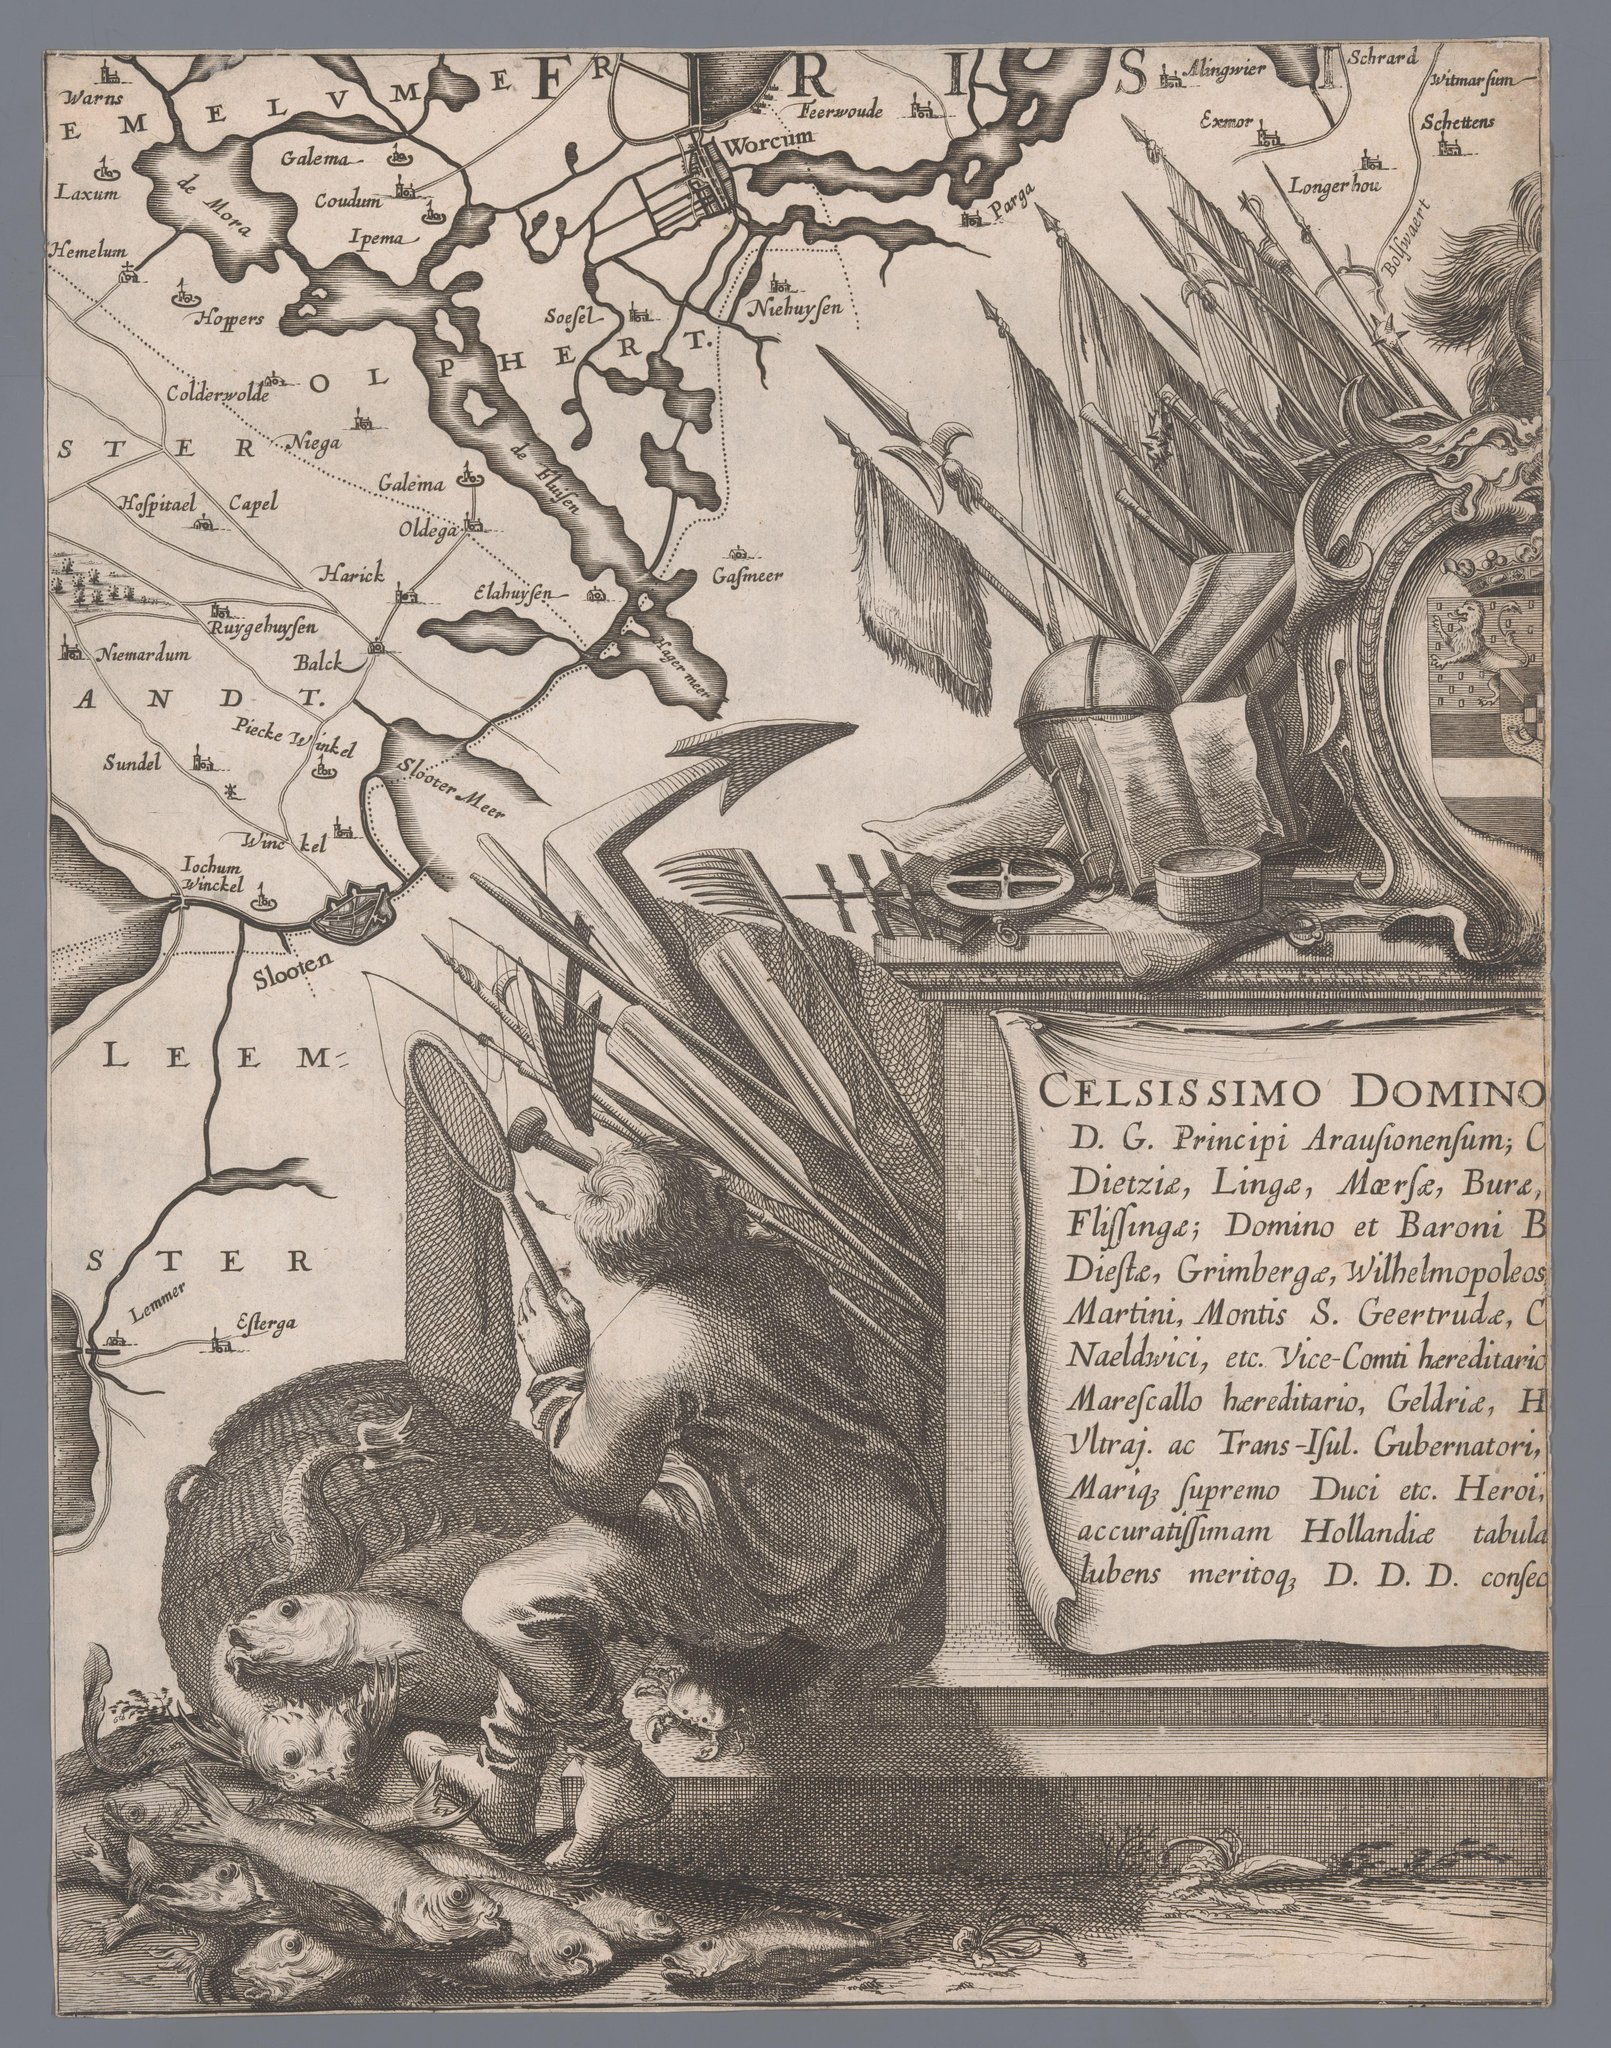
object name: print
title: Kaart van het Graafschap Holland en Utrecht (plaat 39)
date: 1639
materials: paper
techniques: engraving, etching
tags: maps, atlases, fishes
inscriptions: collector's mark: Lugt 2228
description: Onderdeel van een kaart samengesteld uit 40 bladen. Waarschijnlijk gaat het om de grootste kaart van Holland uit de zeventiende-eeuw. De kaart is uitgegeven in verschillende edities, deze kaart uit 1639 is de eerste editie.